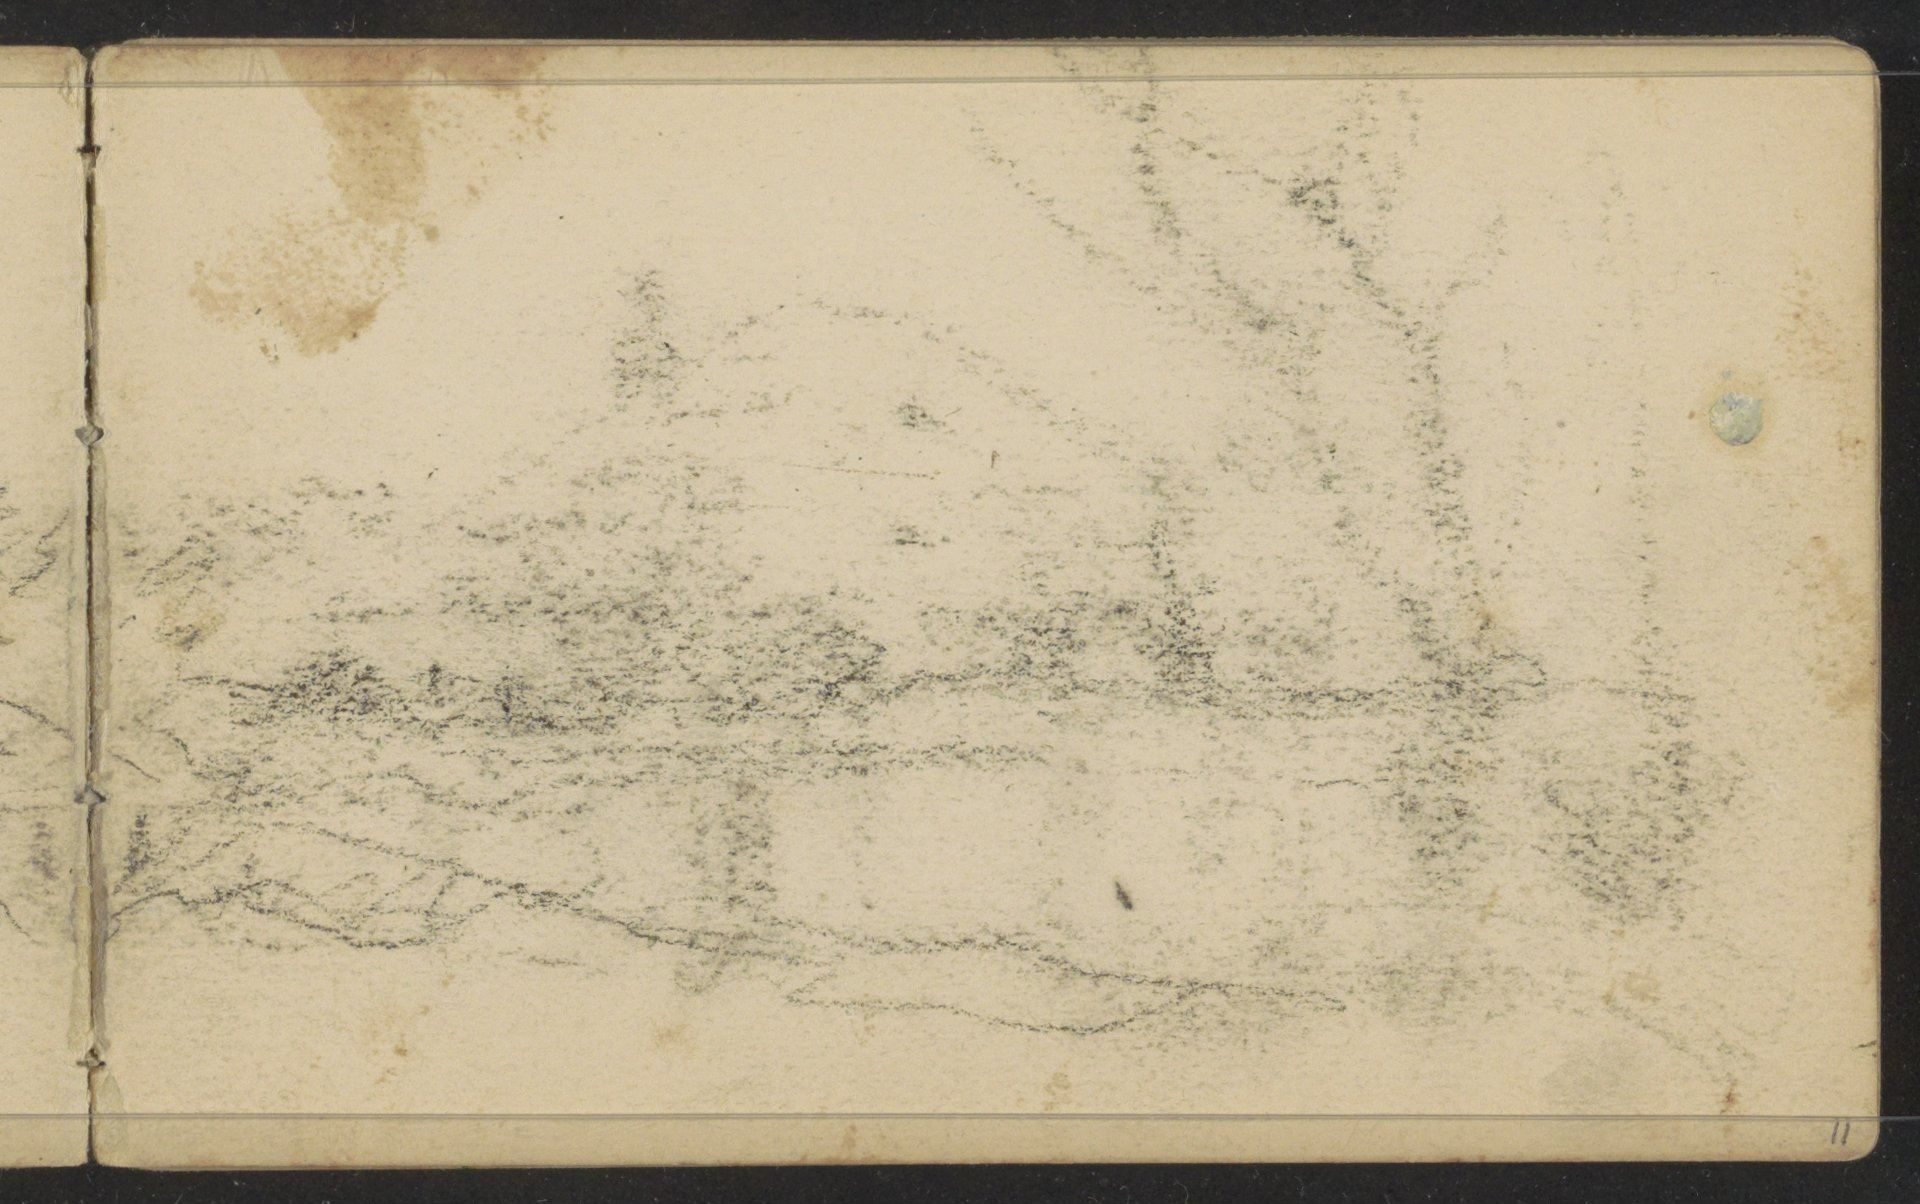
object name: sketchbook leaf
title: Abklatsch van de krijttekening op blad 10 verso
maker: willem cornelis rip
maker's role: draughtsman, painter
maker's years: 1856-1922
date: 1892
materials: paper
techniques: printmaking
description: Blad 11 recto uit een schetsboek met 25 bladen.